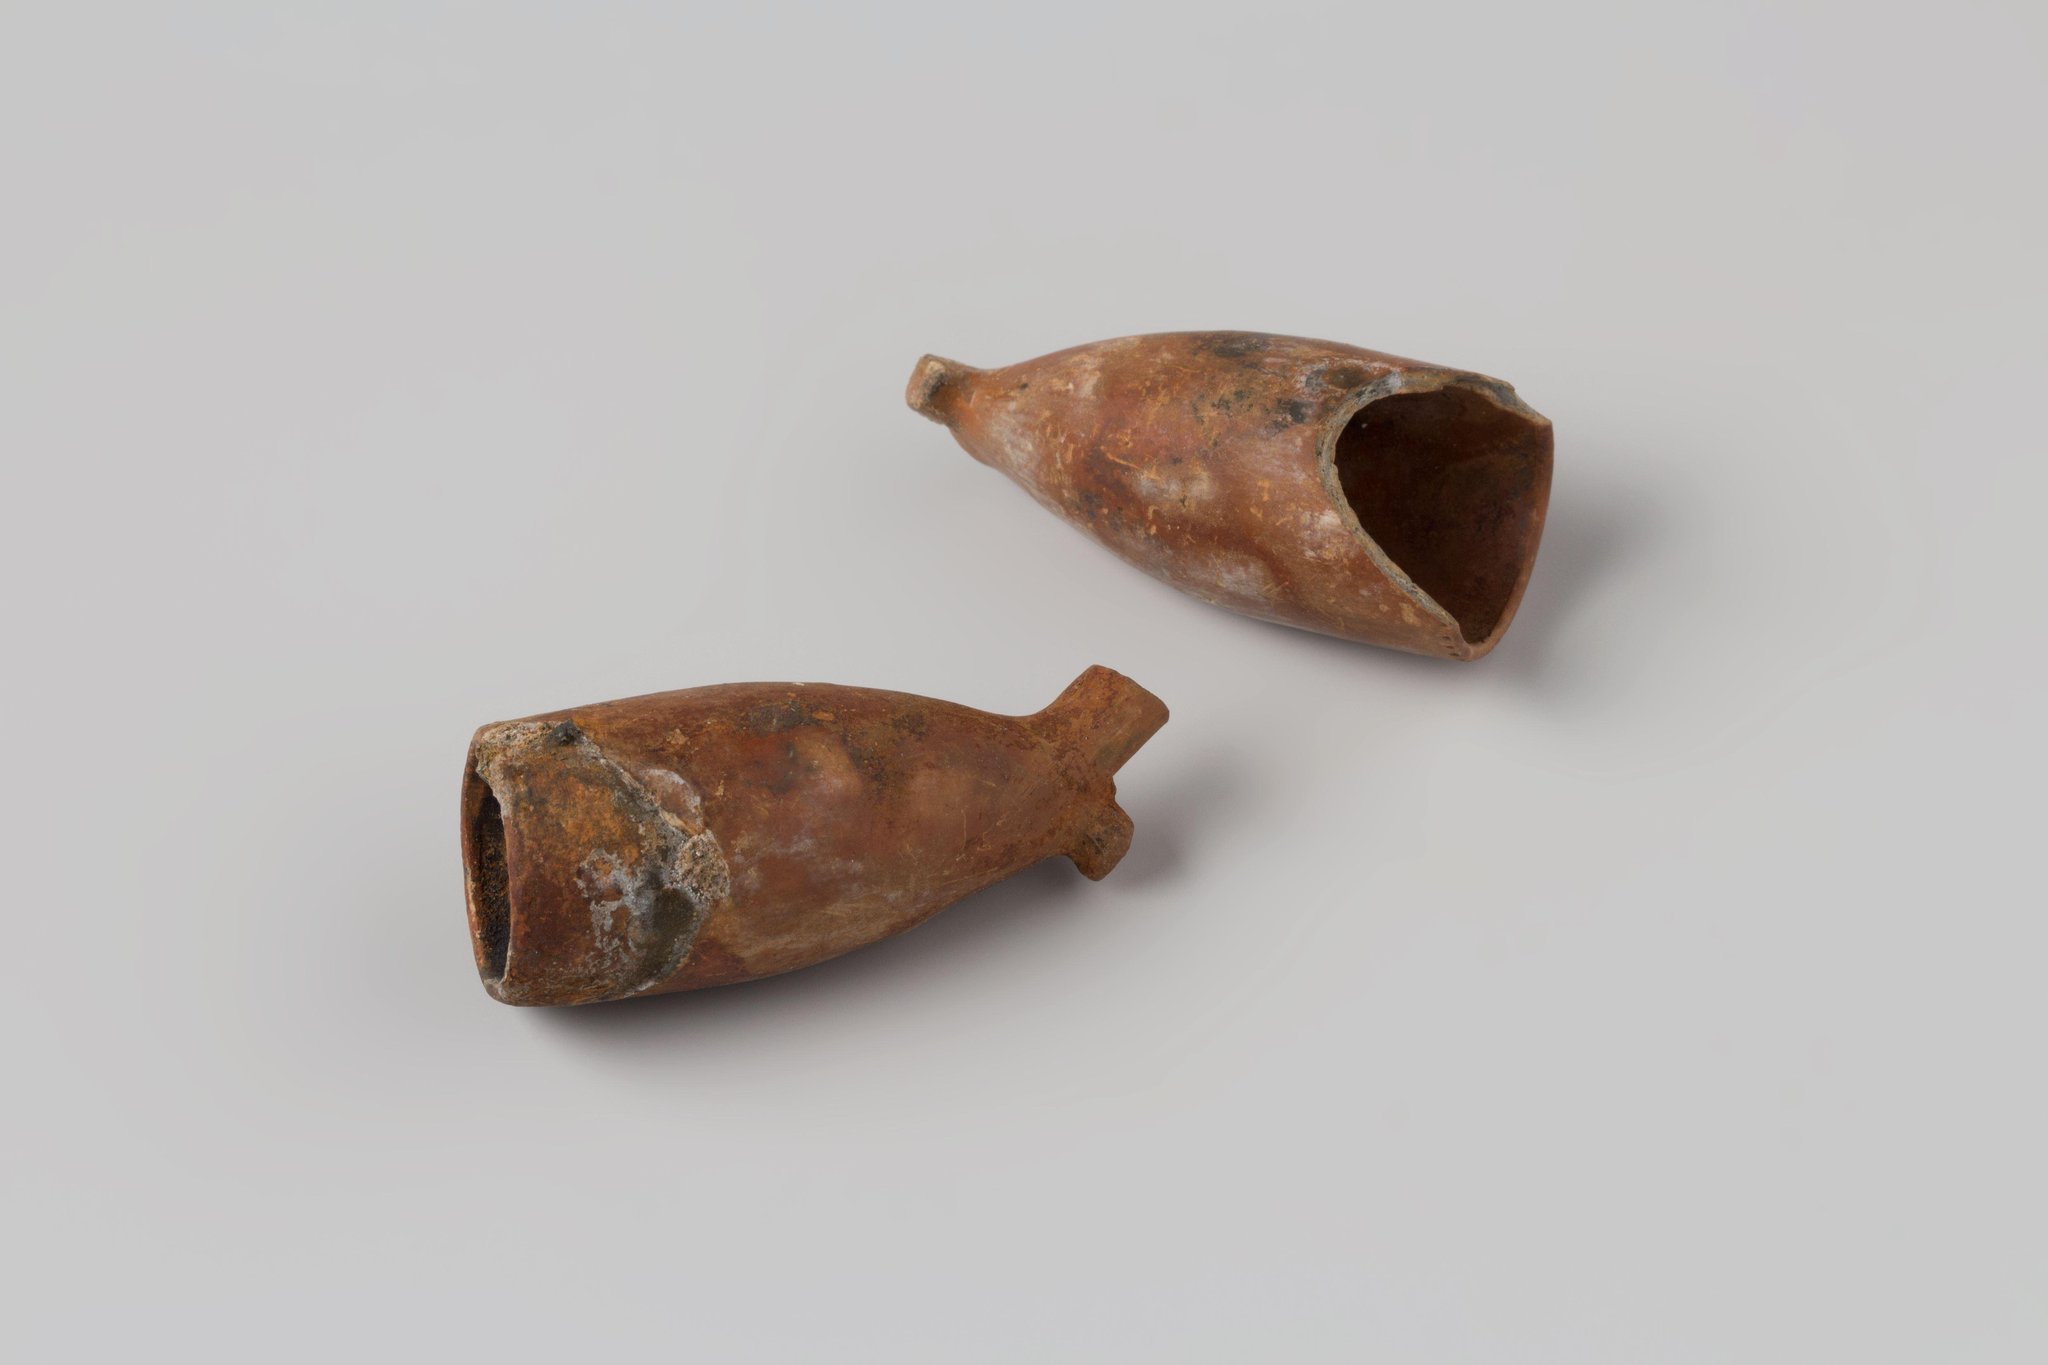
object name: pipe bowl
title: Pijpenkoppen uit het wrak van de Oost-Indiëvaarder Hollandia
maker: Anonymous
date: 1700-1743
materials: clay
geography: netherlands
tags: verenigde oostindische compagnie, hollandia (schip), annet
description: Pipe, bowl, heelmark: crowned 47; 2hsm3, 2hsm1,3.